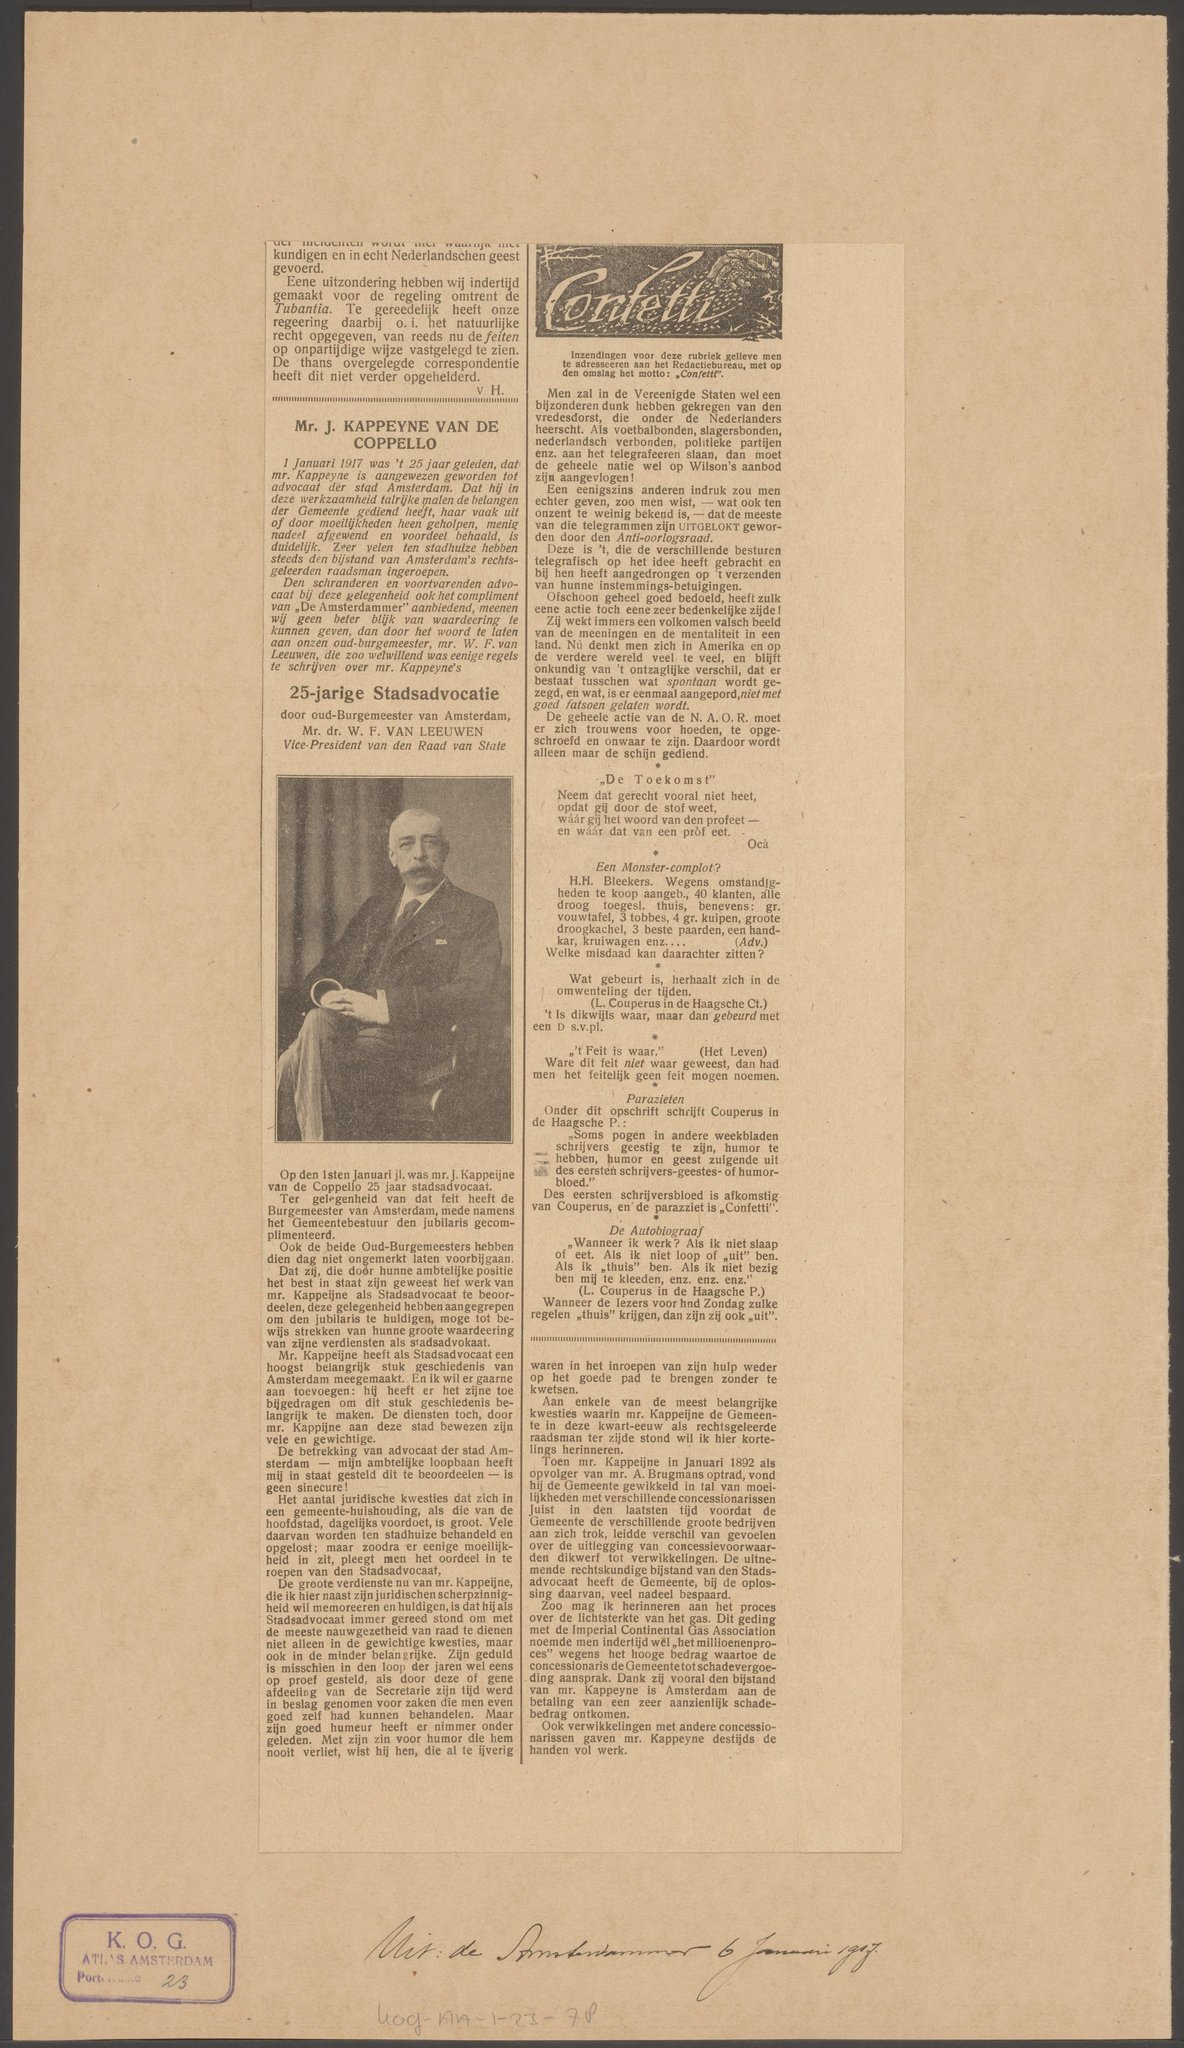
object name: newspaper clipping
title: Portret van Jacobus Kappeyne van de Coppello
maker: Anonymous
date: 1917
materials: paper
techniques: letterpress printing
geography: netherlands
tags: gouda, historical persons, amsterdam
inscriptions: collector's mark: Lugt 1641b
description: Prent uit: De Amsterdammer 41 (1917), nr. 2063, 6 januari 1917, p. 1.